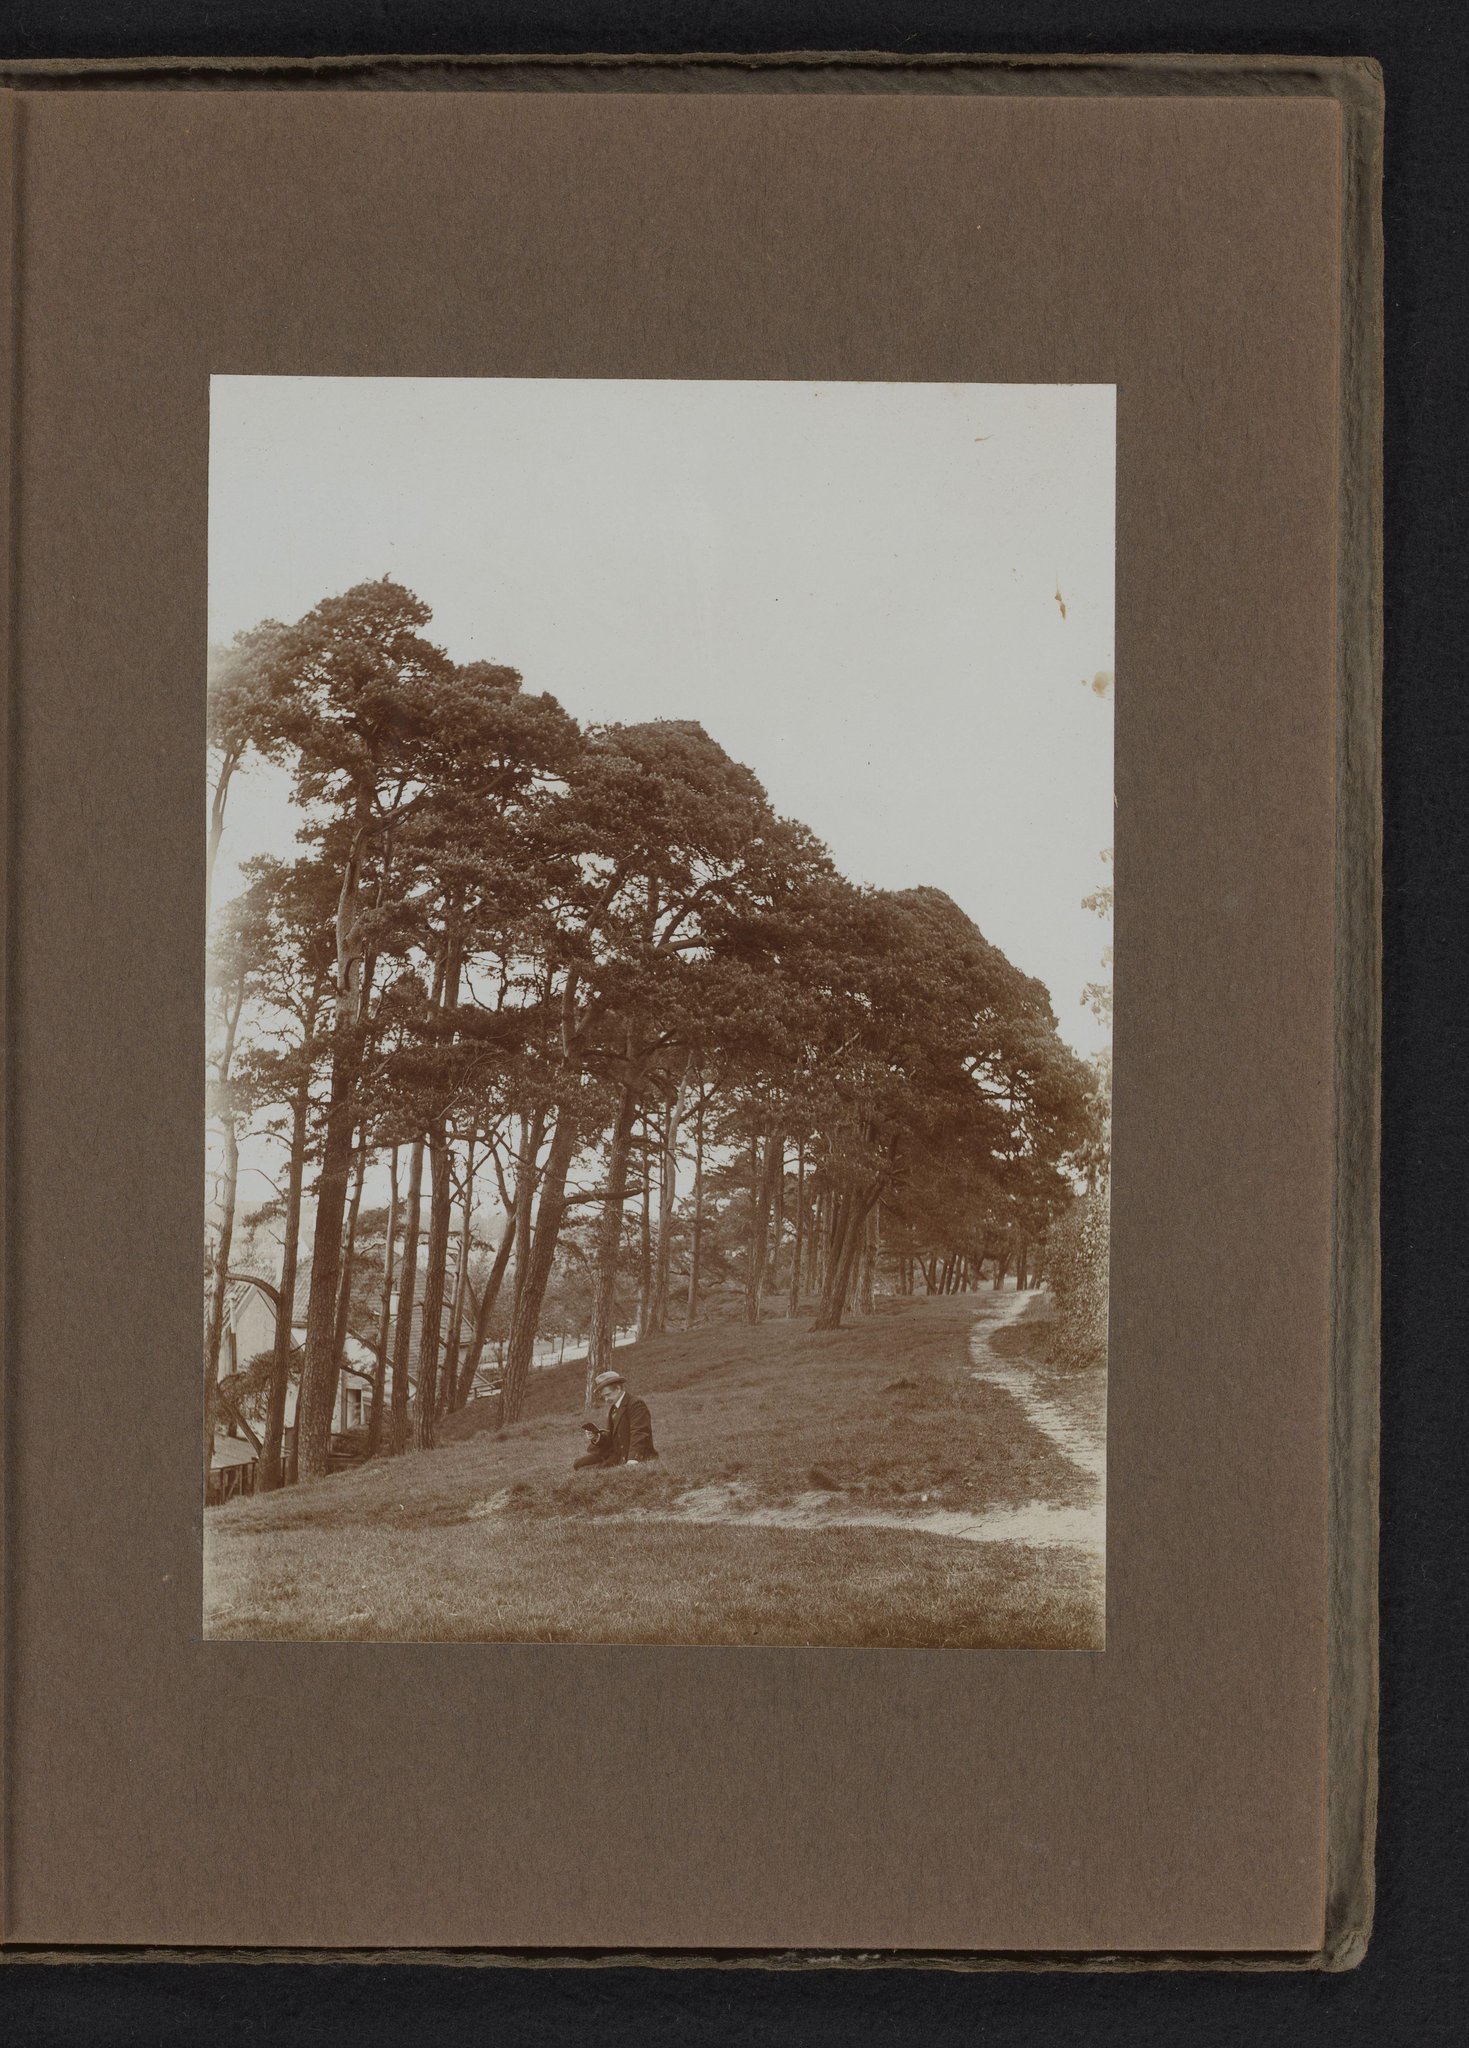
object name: photograph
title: Onbekende lezende man bij een bospad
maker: Anonymous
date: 1905-1920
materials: paper, photographic support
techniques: collodion silver print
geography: netherlands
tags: trees, reading, adult man, forest path or lane